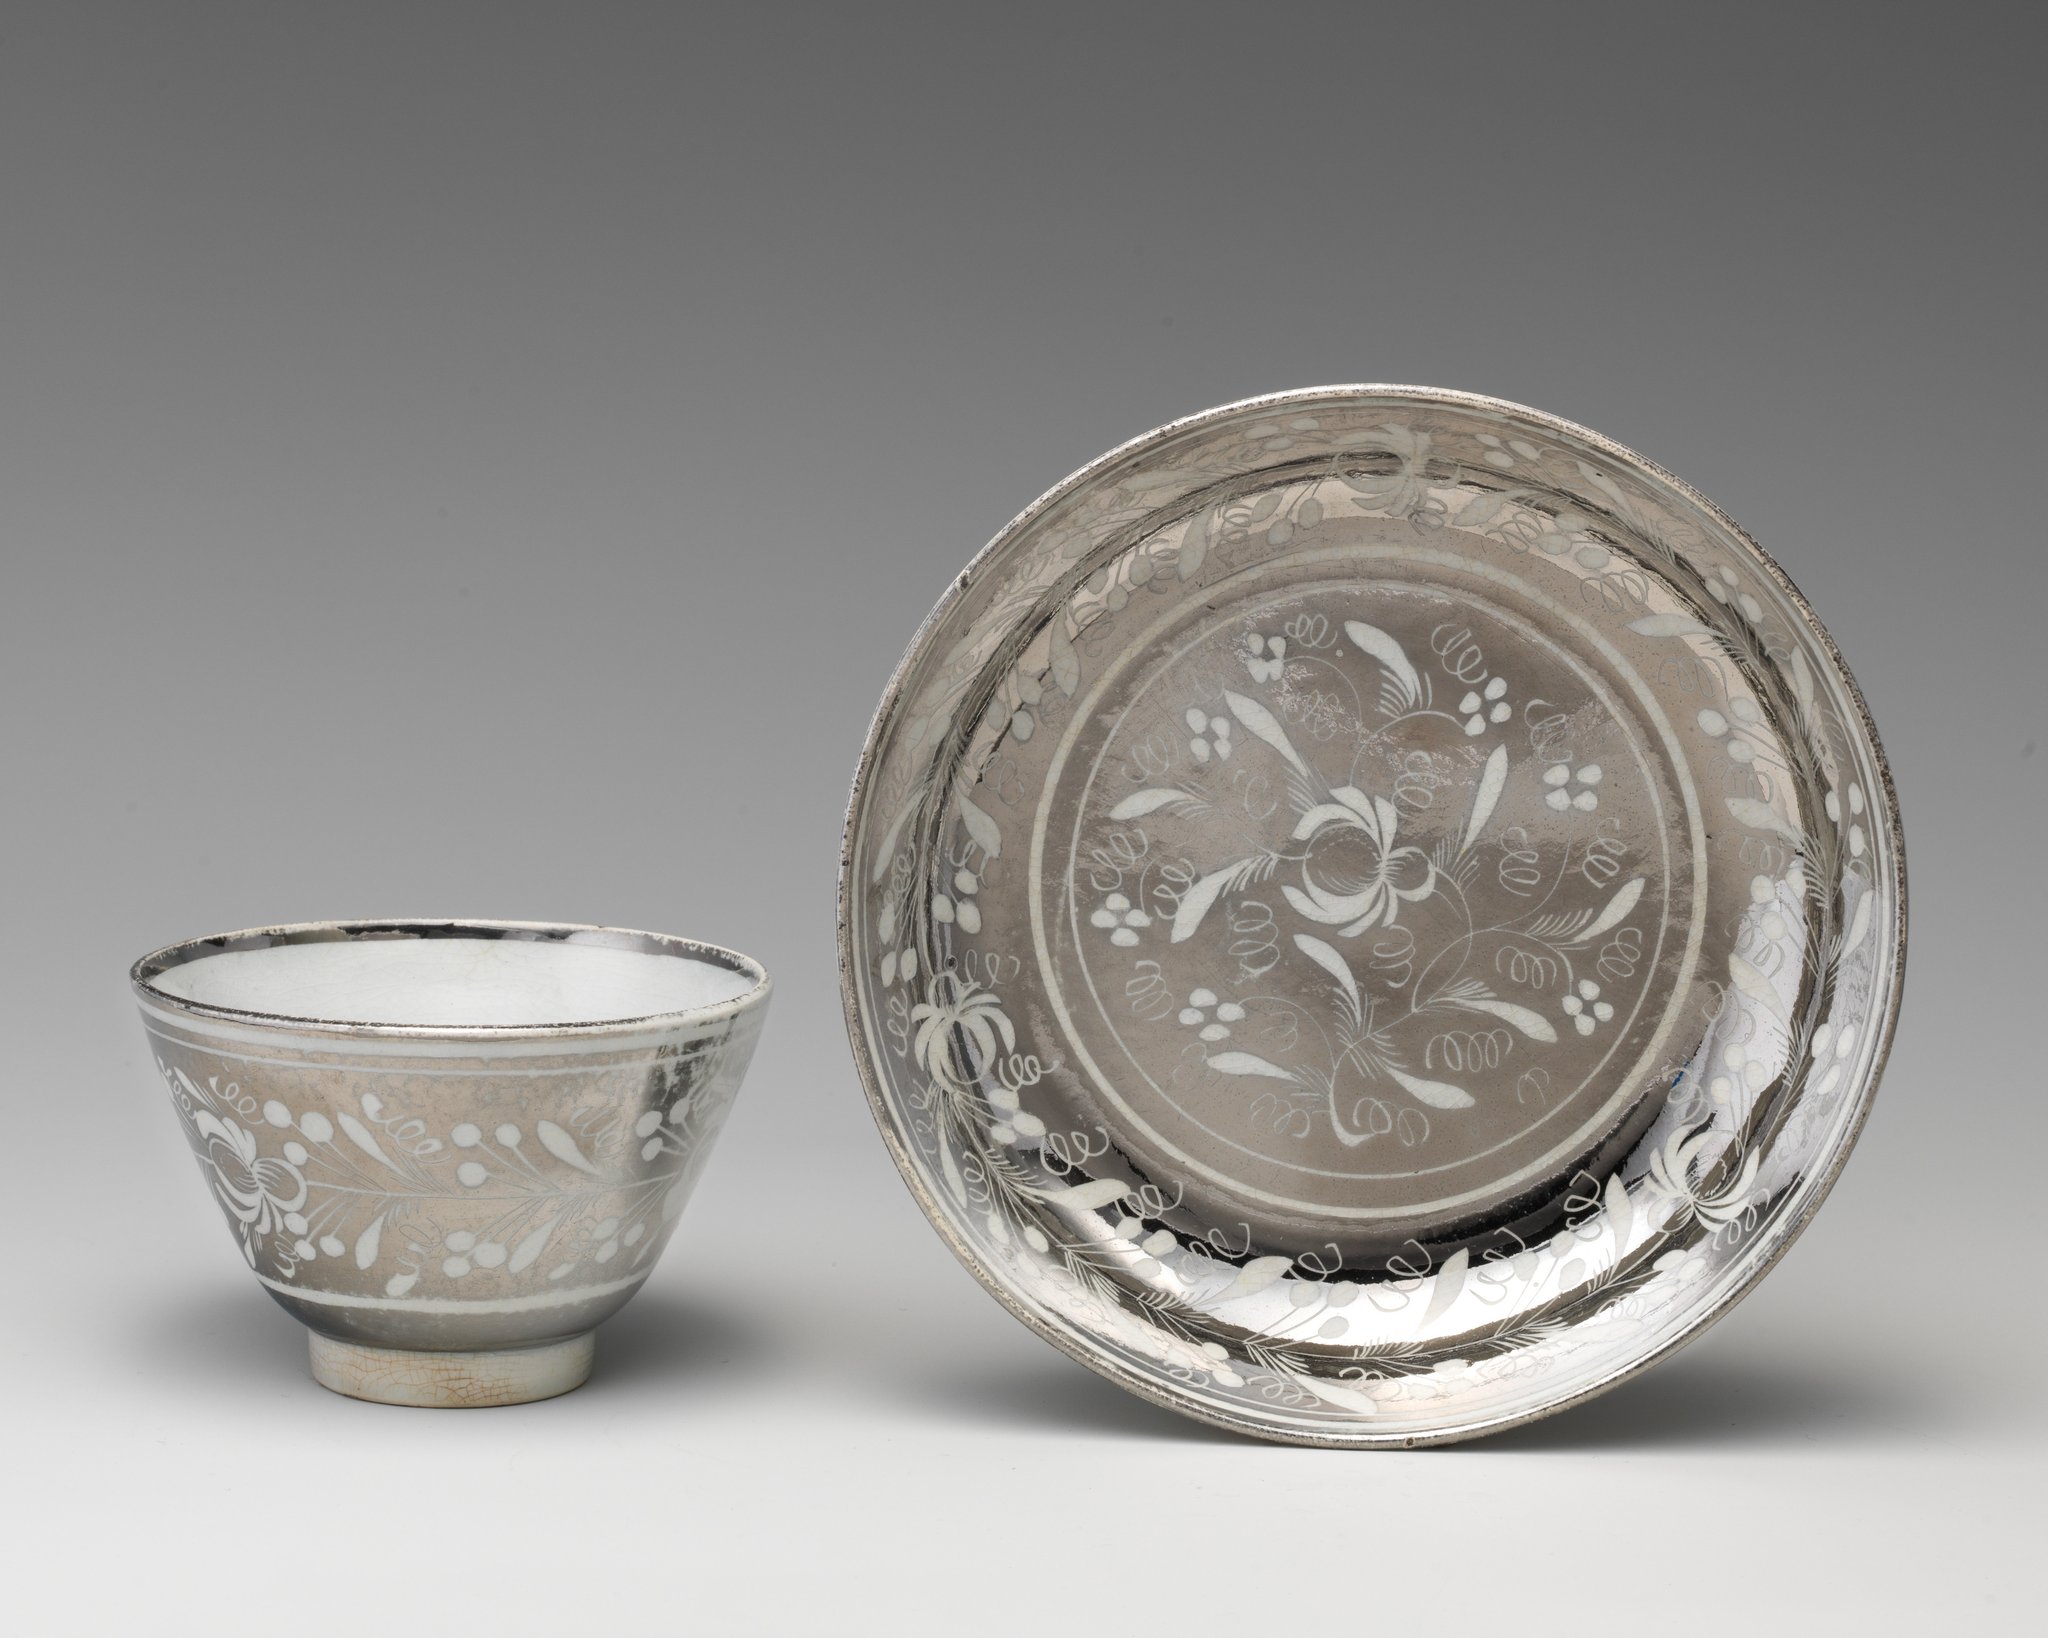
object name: cup and saucer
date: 1801-1833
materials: pottery